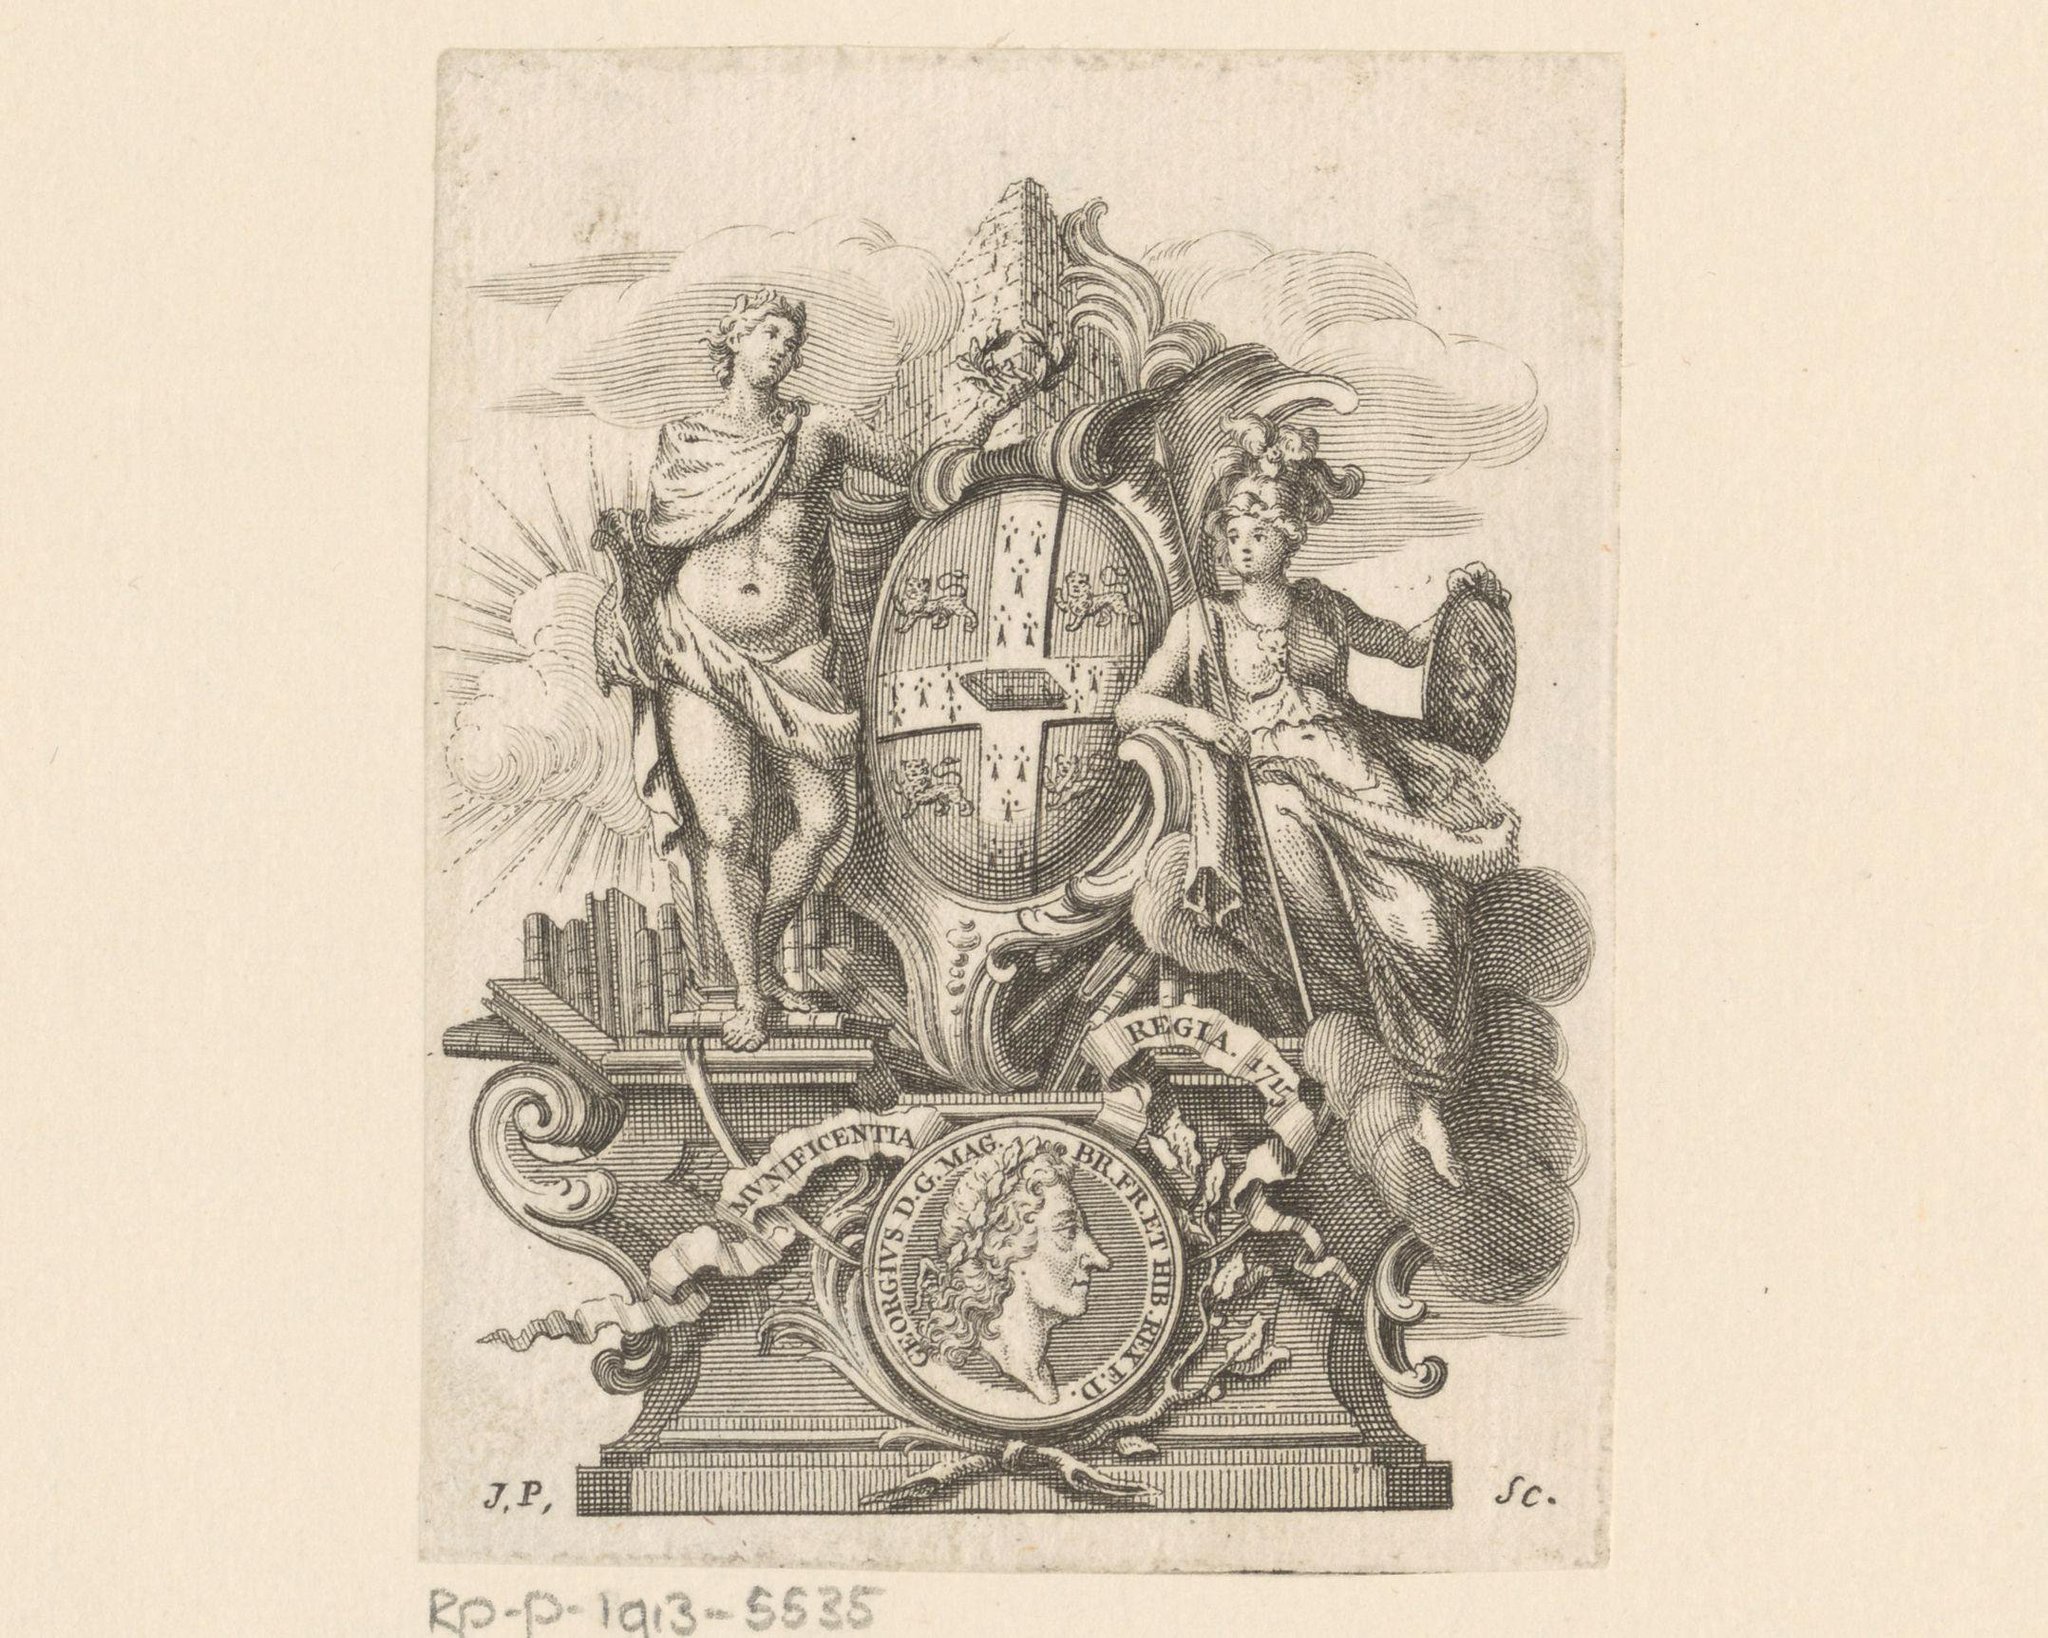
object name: bookplate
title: Ex libris van Cambridge University Library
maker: john pine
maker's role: print maker, publisher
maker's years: 1690-1756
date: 1715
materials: paper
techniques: engraving, etching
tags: library, george i (koning van groot-brittannië en ierland), armorial bearing, heraldry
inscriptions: collector's mark: Lugt 2760, collector's mark: Lugt 2233